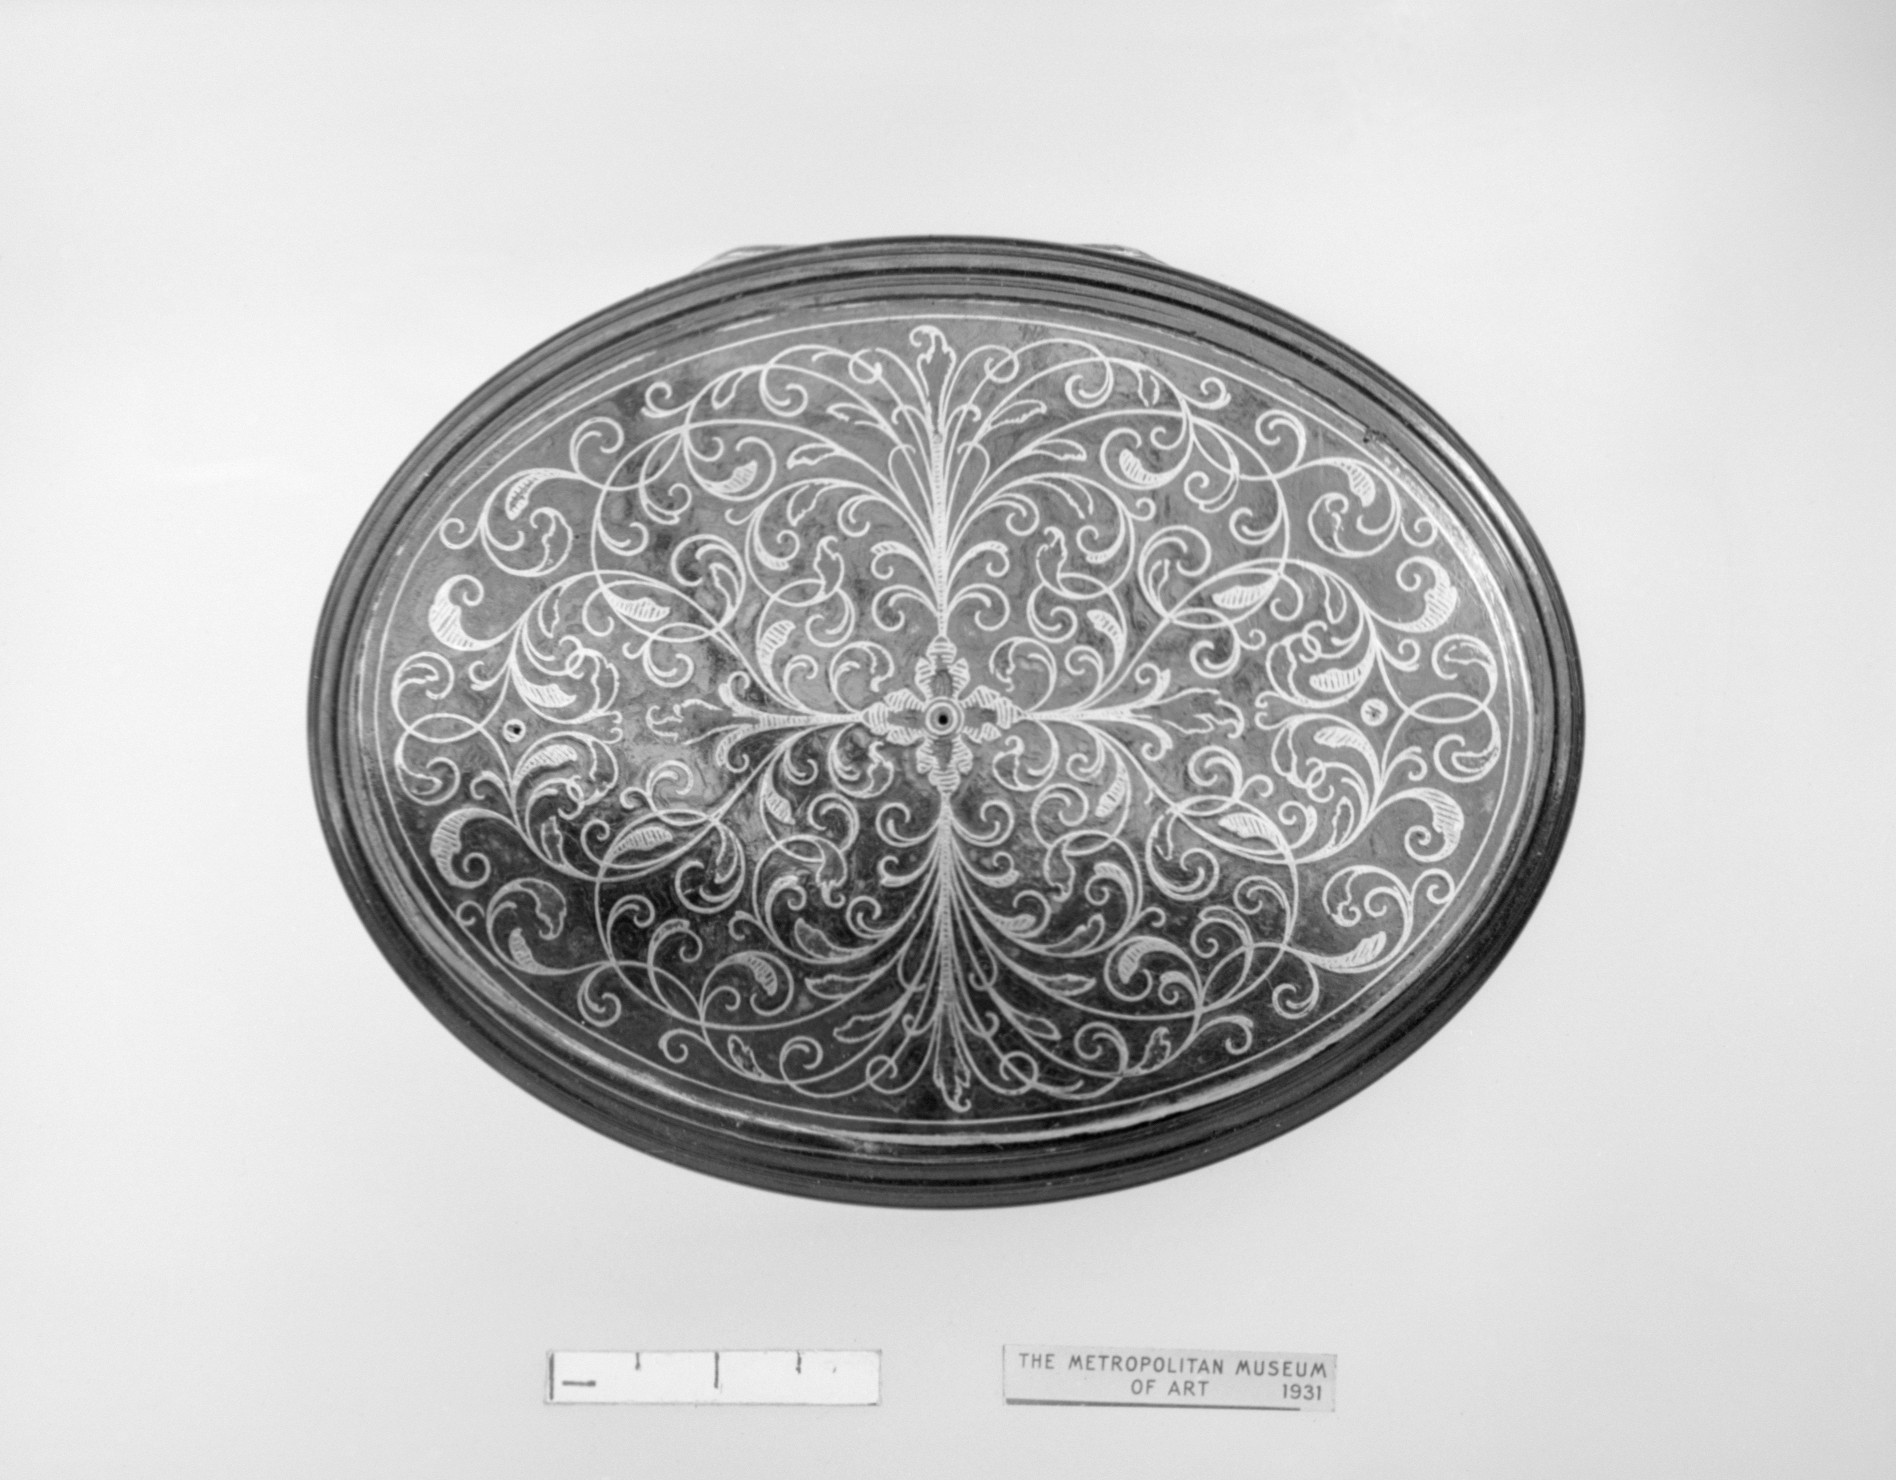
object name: box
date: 1601-1700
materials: brass, shell